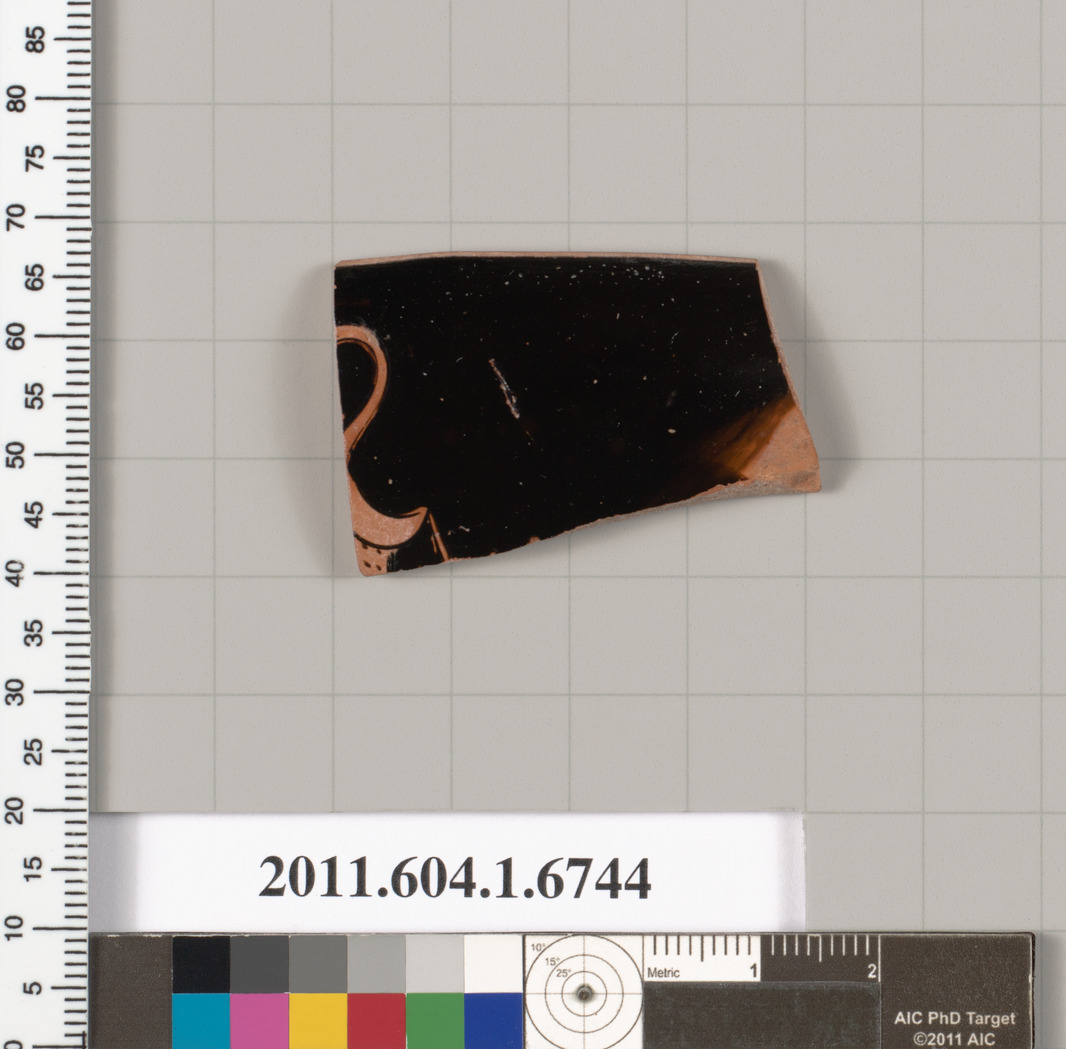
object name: kylix fragment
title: Terracotta rim fragment of a kylix (drinking cup)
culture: greek, attic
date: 490-470 BCE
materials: terracotta